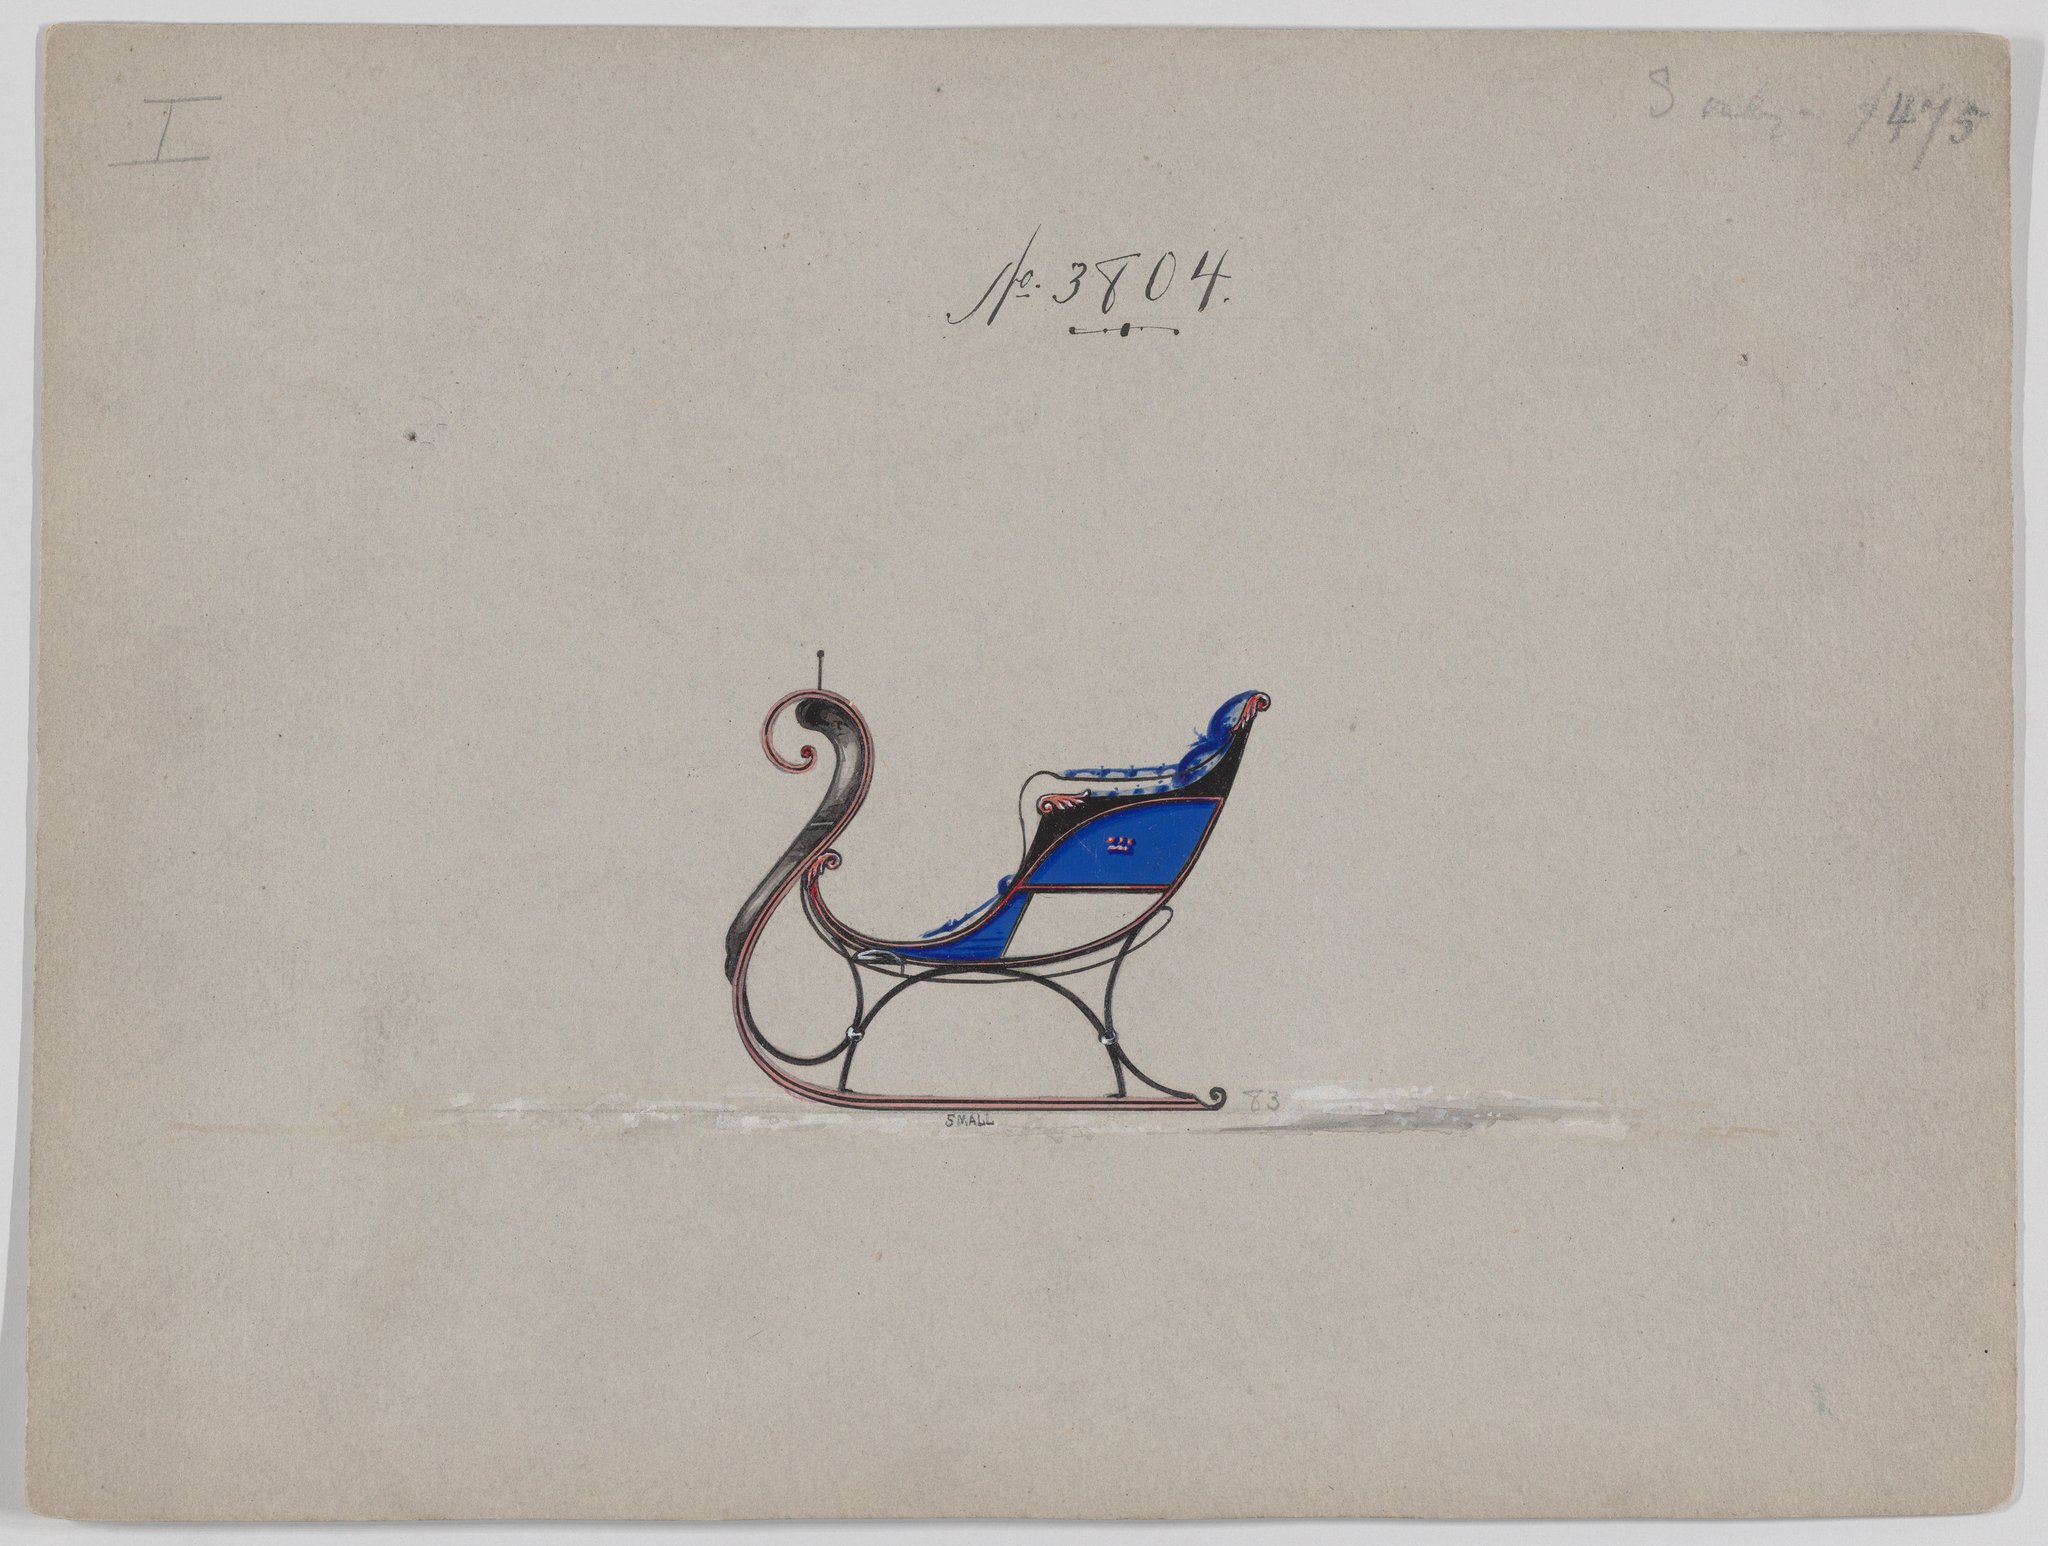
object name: drawing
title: Half Panel Cutter #3804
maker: brewster & co.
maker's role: manufacturer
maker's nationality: american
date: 1883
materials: gouache, gum arabic, ink, watercolor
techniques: pen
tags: sleighs